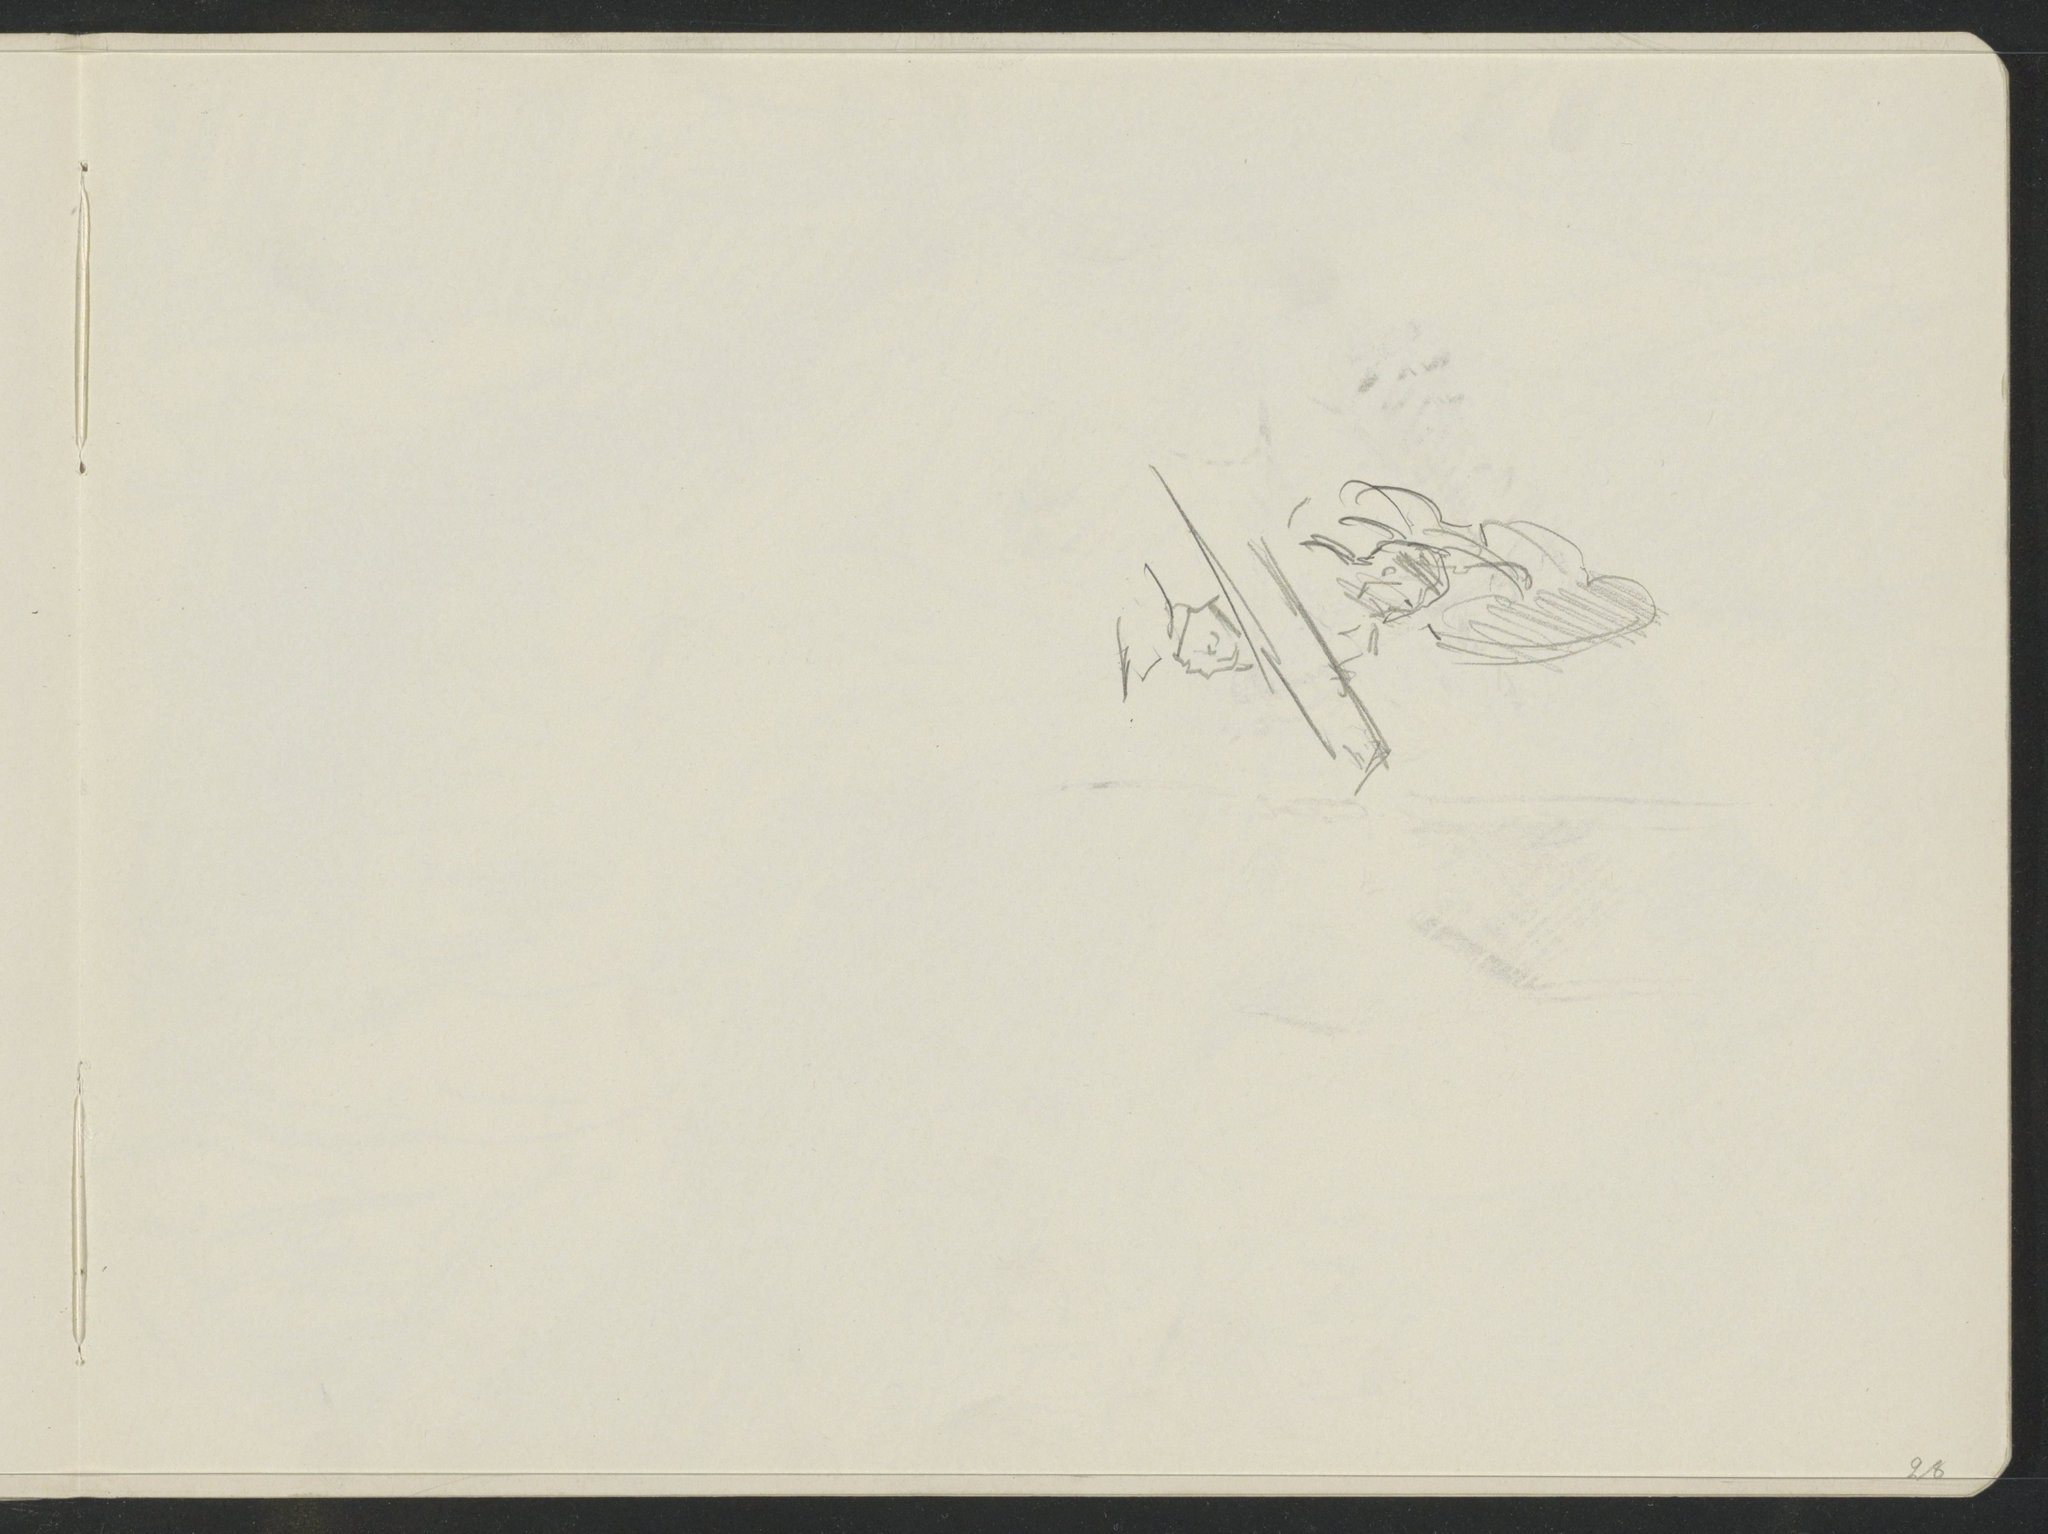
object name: sketchbook leaf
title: Figuurstudies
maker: isaac israels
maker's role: draughtsman, painter, print maker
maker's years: 1865-1934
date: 1915-1934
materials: paper, pencil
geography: the hague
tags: adult man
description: Blad 28 recto uit schetsboek XVII met 31 bladen.